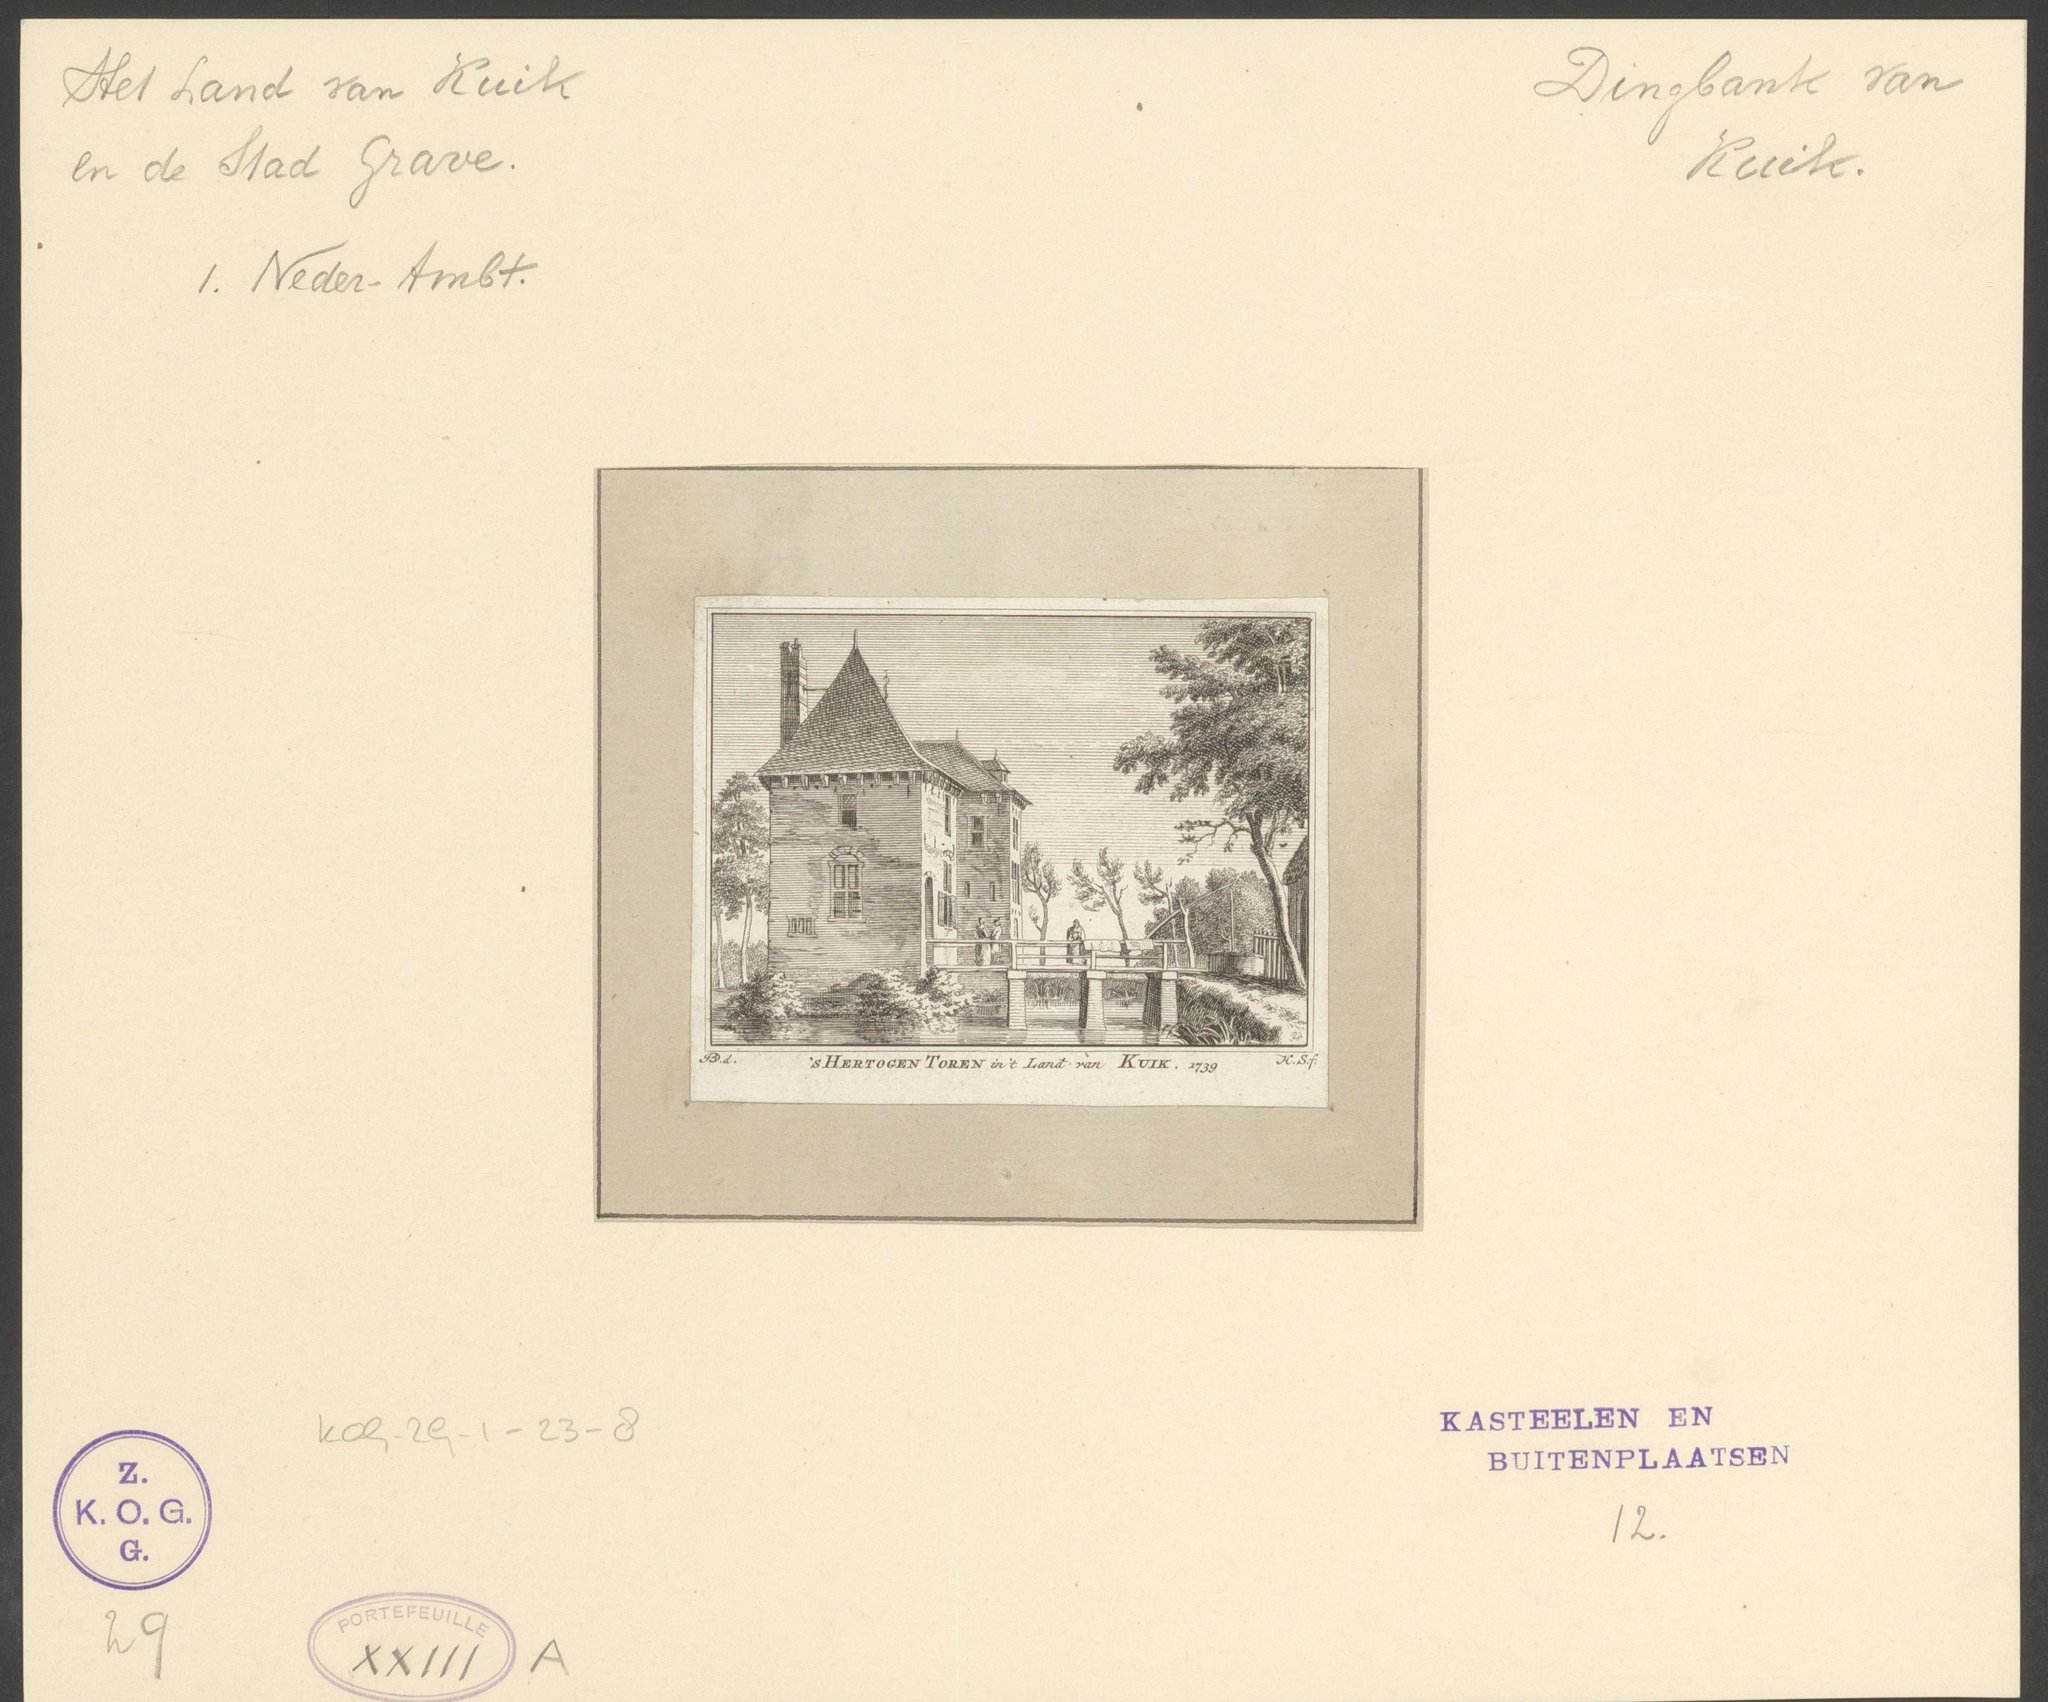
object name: print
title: 's Hertogentoren in 't land van Kuik. 1739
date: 1745-1746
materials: paper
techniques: engraving, etching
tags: abbey, monastery, convent ~ roman catholic church, ruin of a dwelling, house, castle, etc.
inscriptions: collector's mark: Lugt 1641, stamp, stamp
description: Gezicht op de 's-Hertogentoren in Groeningen, in de situatie omstreeks 1739. Onderwerpsrubrieken binnen de Atlas Zeden en Gewoonten: Zeden en Gewoonten in Engeren Zin, De Woning. Kastelen en buitenplaatsen. Generaliteitslanden.